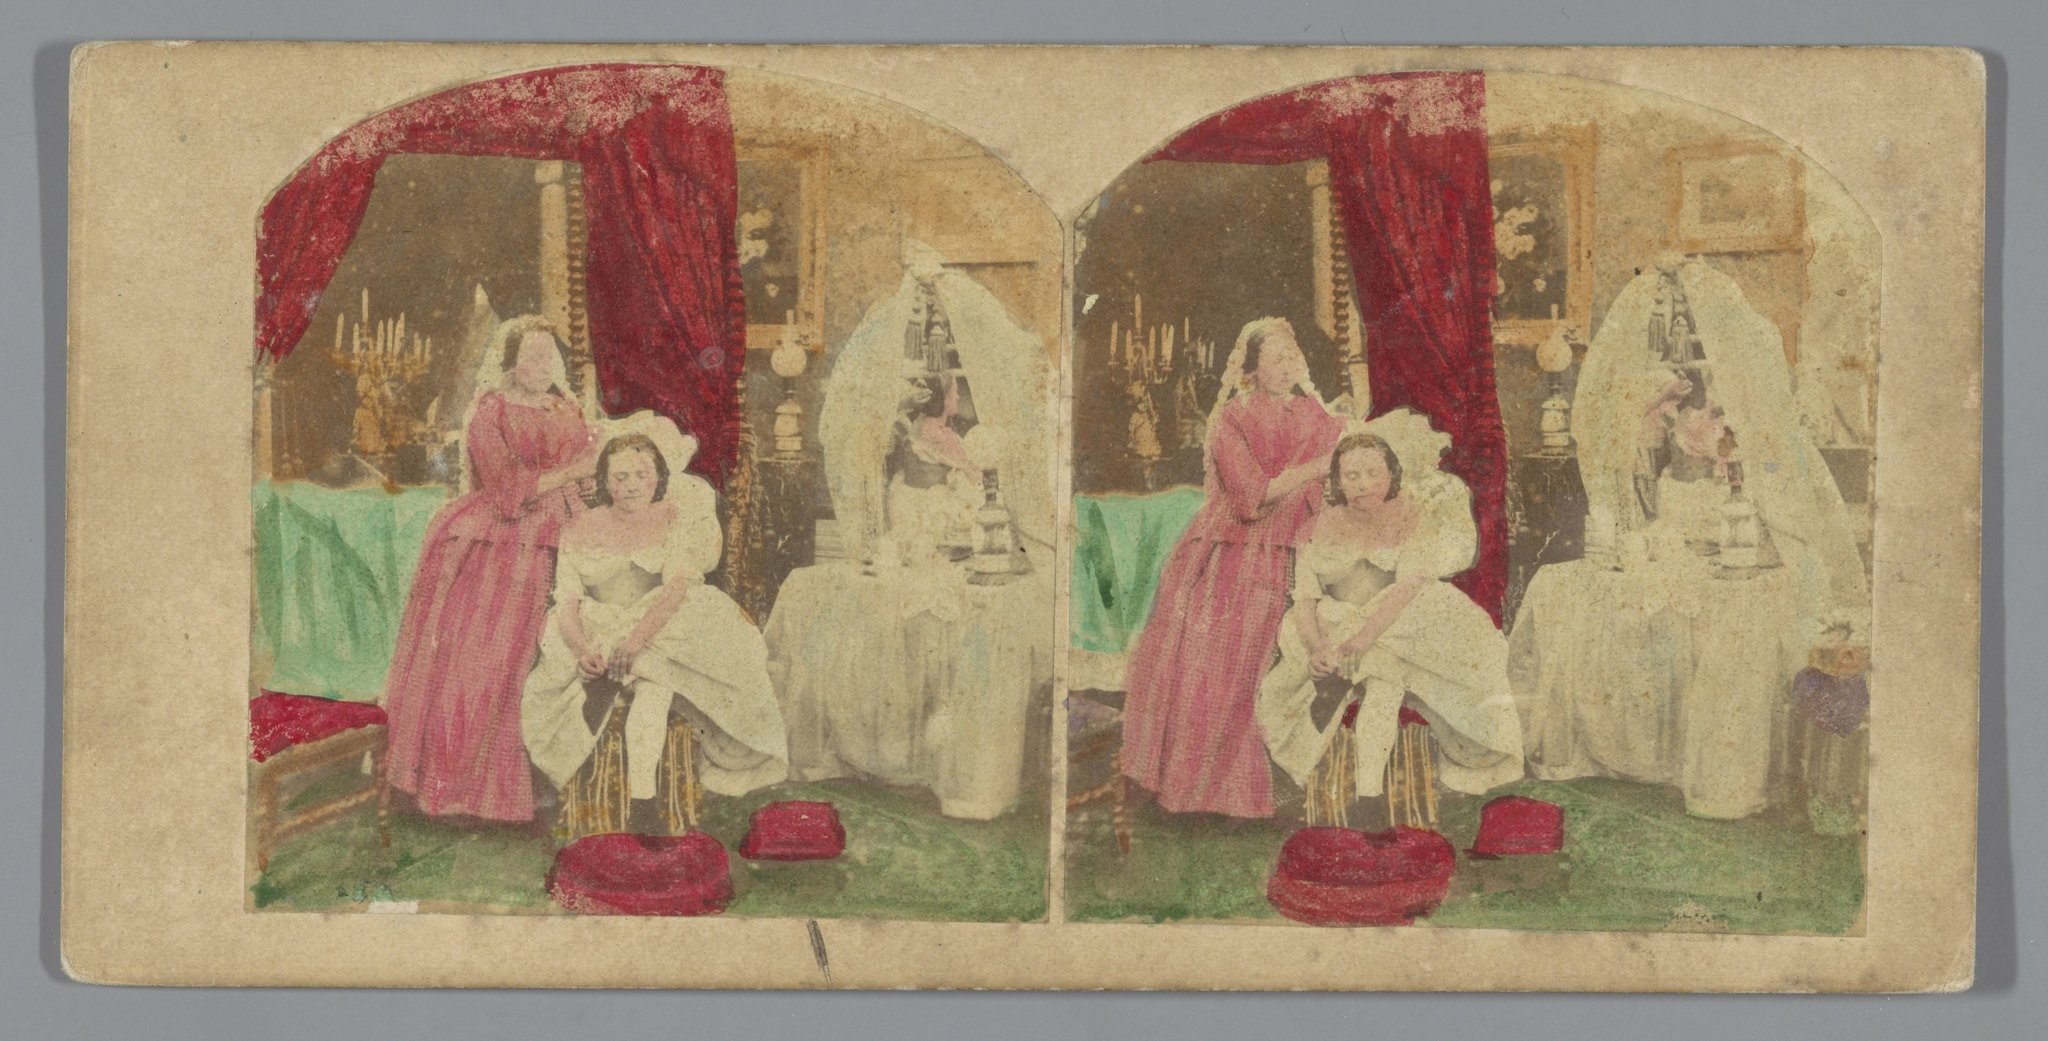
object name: stereograph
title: Twee vrouwen wassen zich in een boudoir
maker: Anonymous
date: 1852-1863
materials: cardboard, paper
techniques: albumen print, hand coloring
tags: making toilet, boudoir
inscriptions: inscription: ‘123’, inscription: ‘P’, inscription: ‘[...] 80’